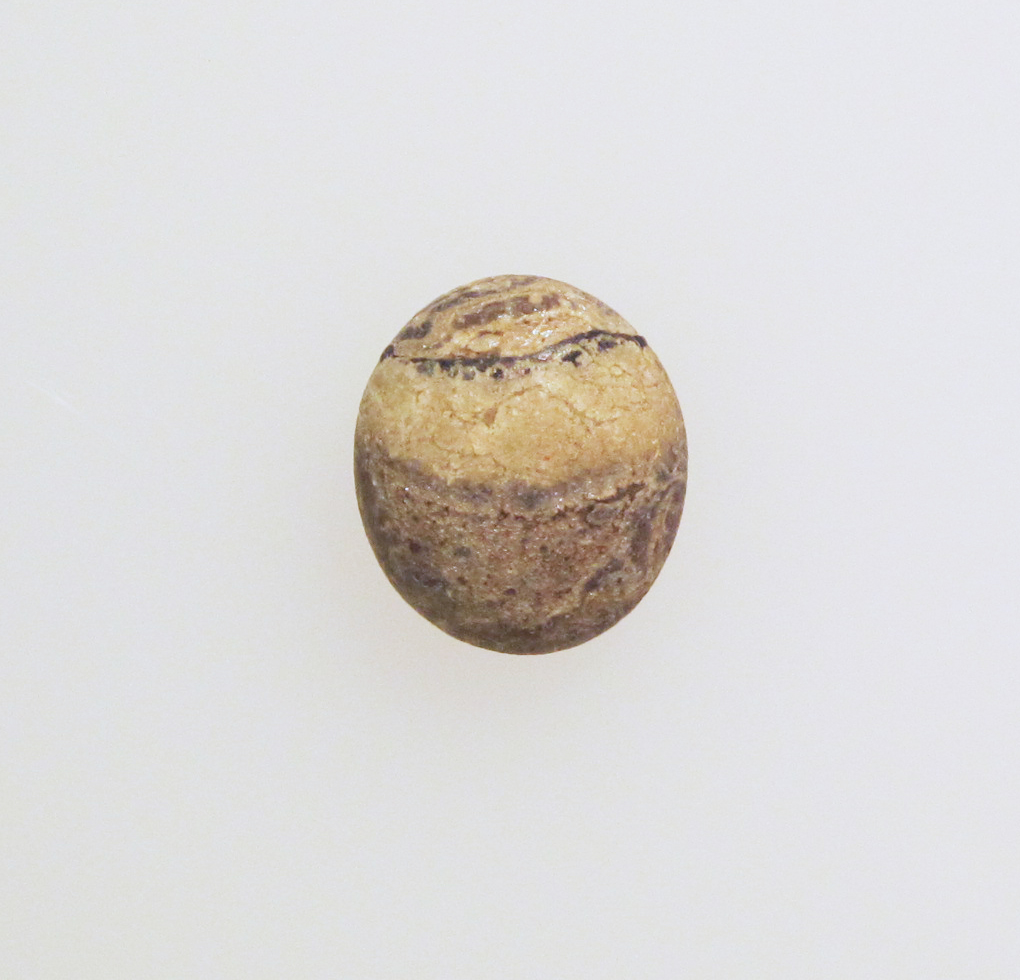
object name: pinhead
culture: roman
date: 100 BCE-500 CE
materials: glass